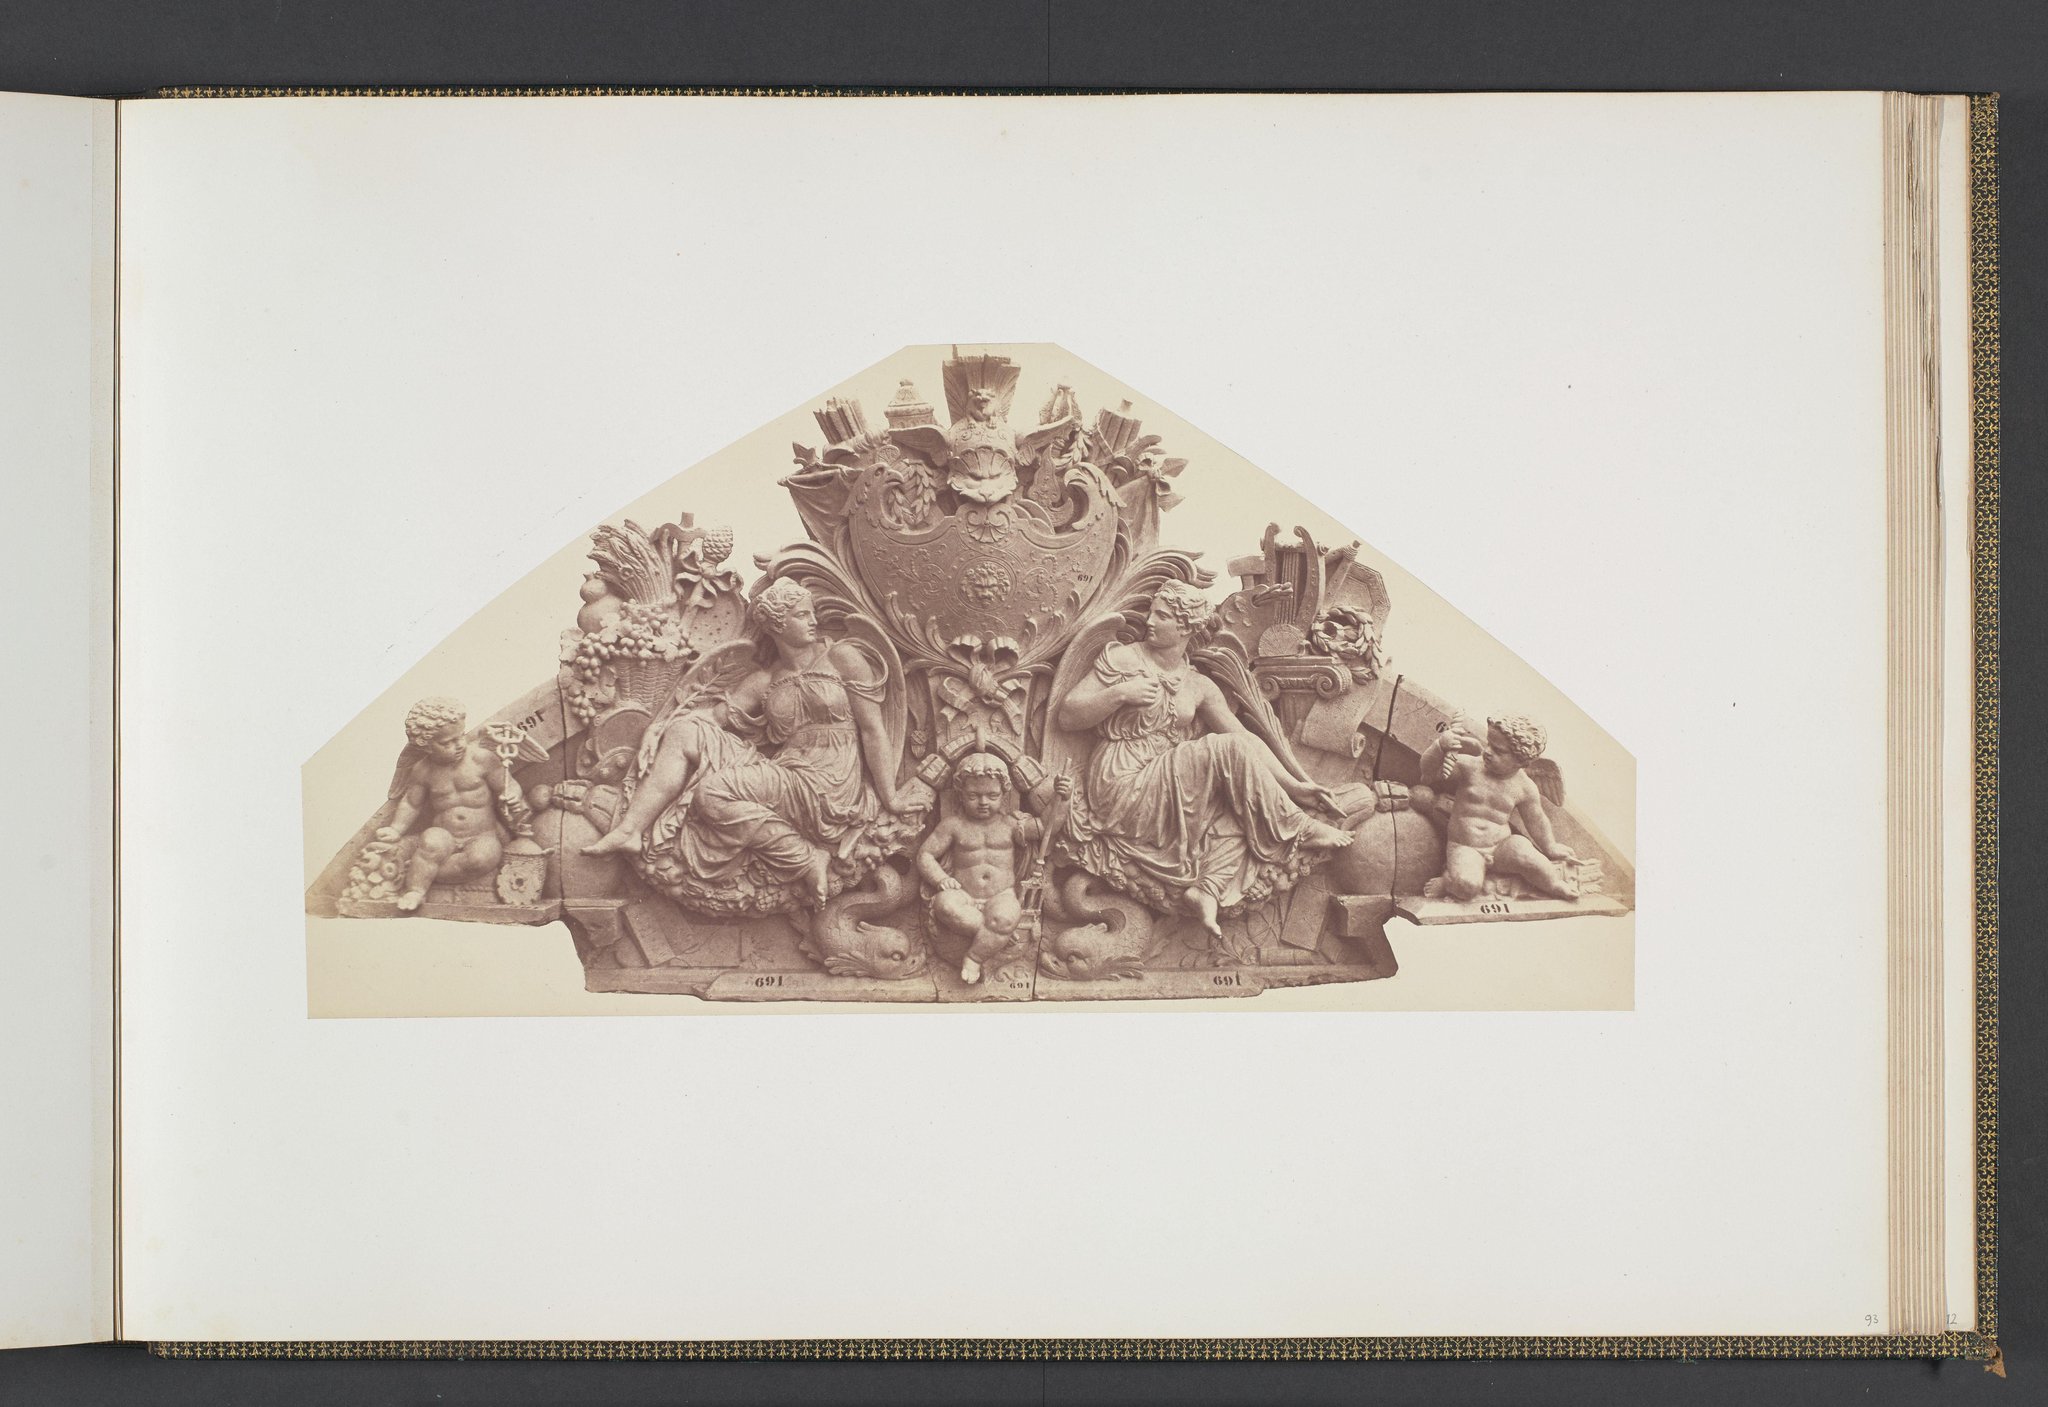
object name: album leaf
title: Gipsmodellen voor beeldhouwwerken op het Palais du Louvre: "L'Agriculture et les Arts" door Eugène Louis Lequesne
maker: édouard denis baldus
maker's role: fotograaf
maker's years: 1813-1889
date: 1855-1857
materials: paper, photographic support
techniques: salted paper print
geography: paris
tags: piece of sculpture, reproduction of a piece of sculpture, permanent exhibition, museum, paris, tuileries palace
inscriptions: number: ‘691’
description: Onderdeel van Réunion des Tuileries au Louvre 1852-1857, album 2.